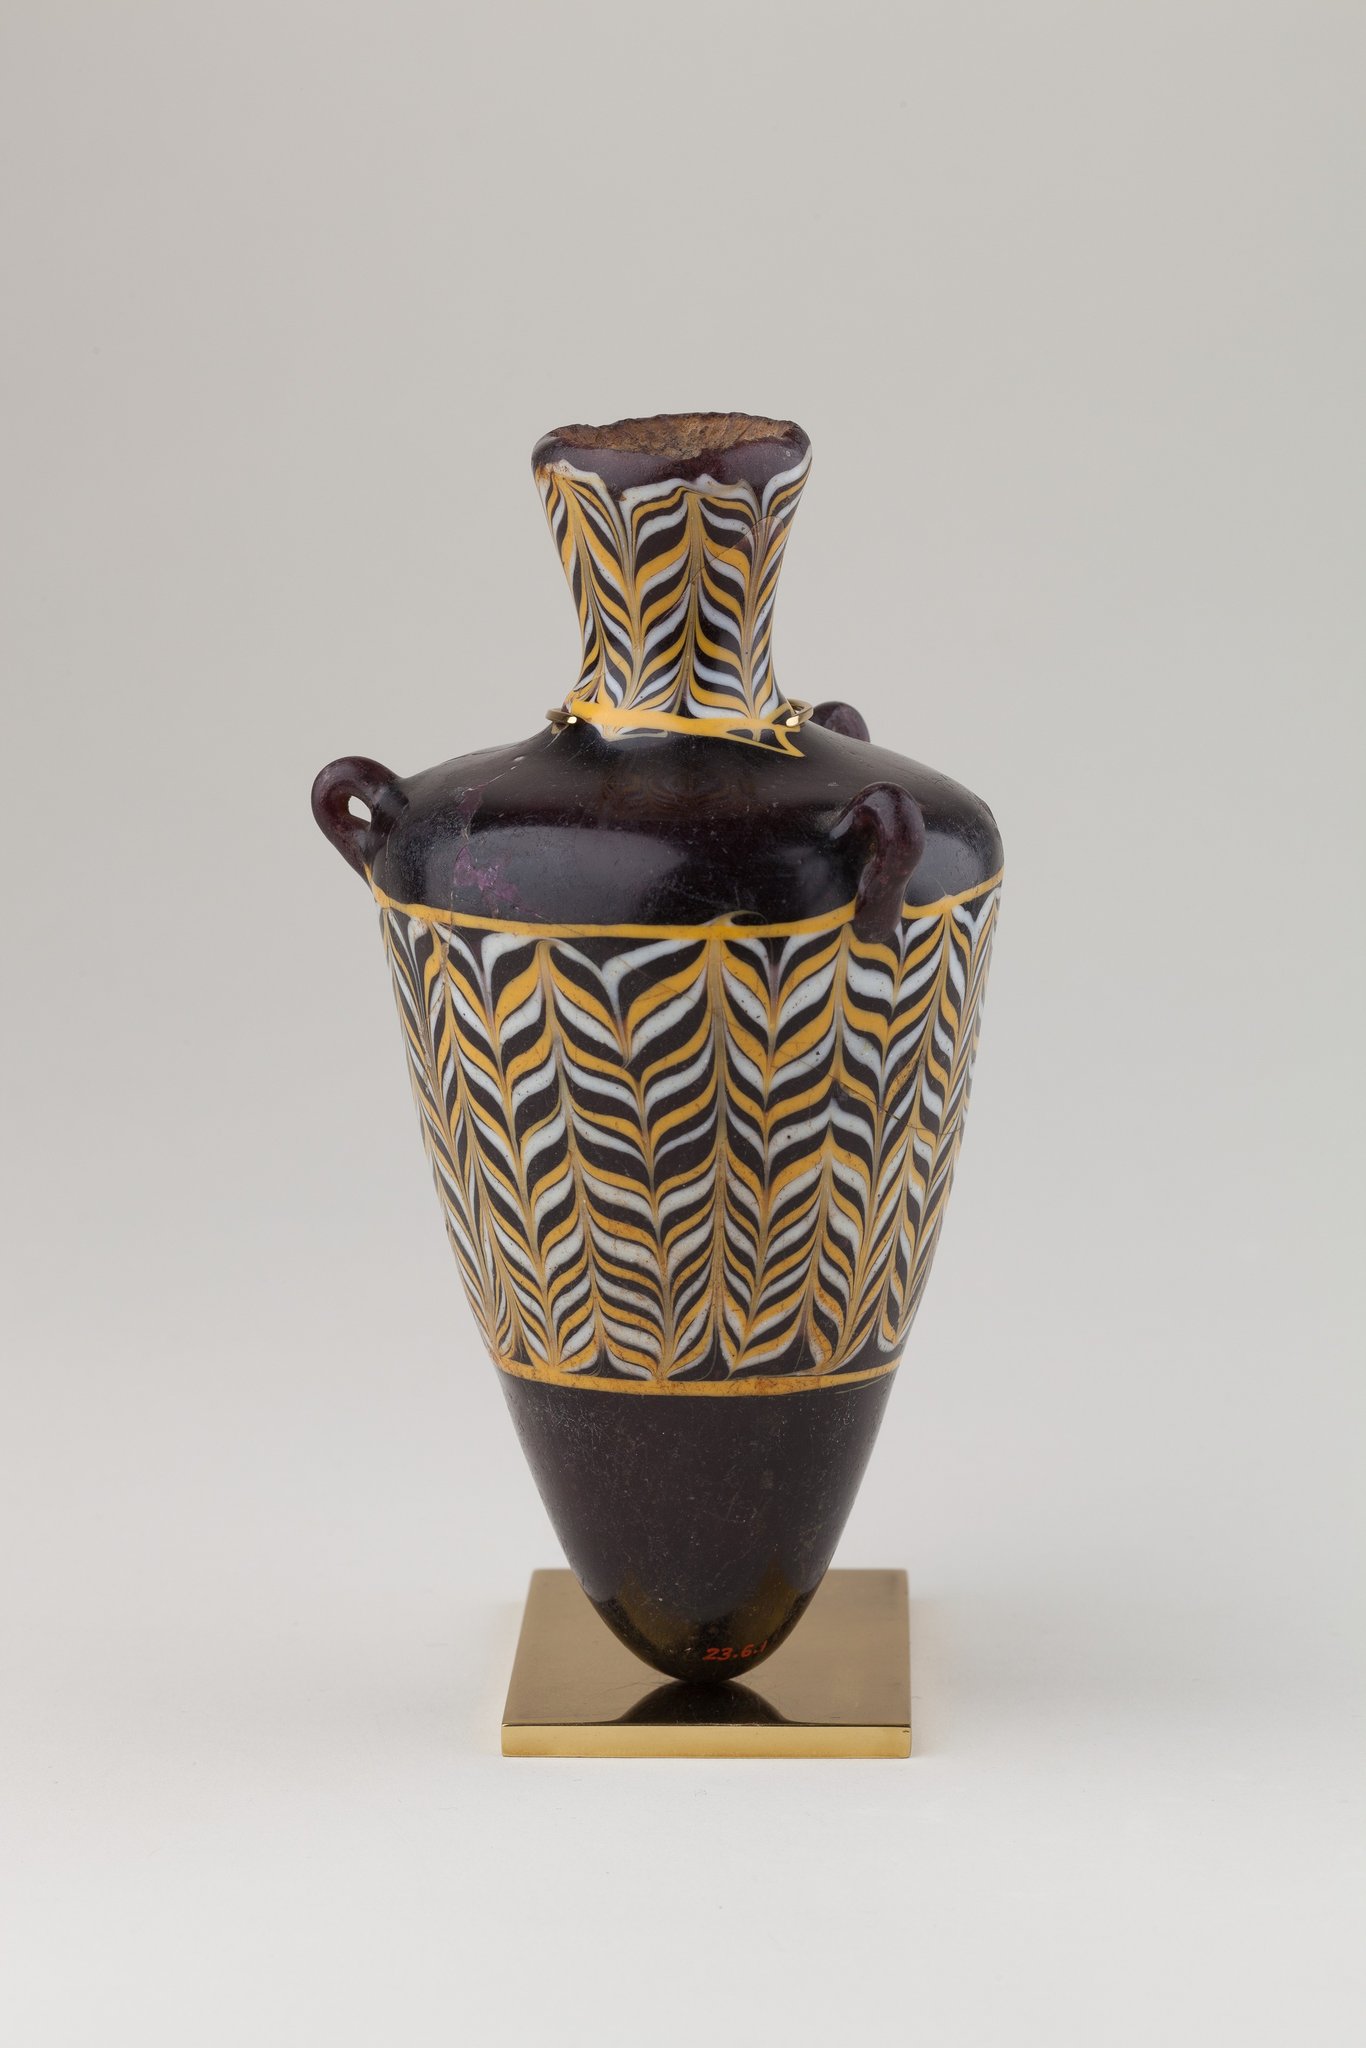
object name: vase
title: Glass Vessel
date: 1295-1070 BCE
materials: glass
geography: egypt